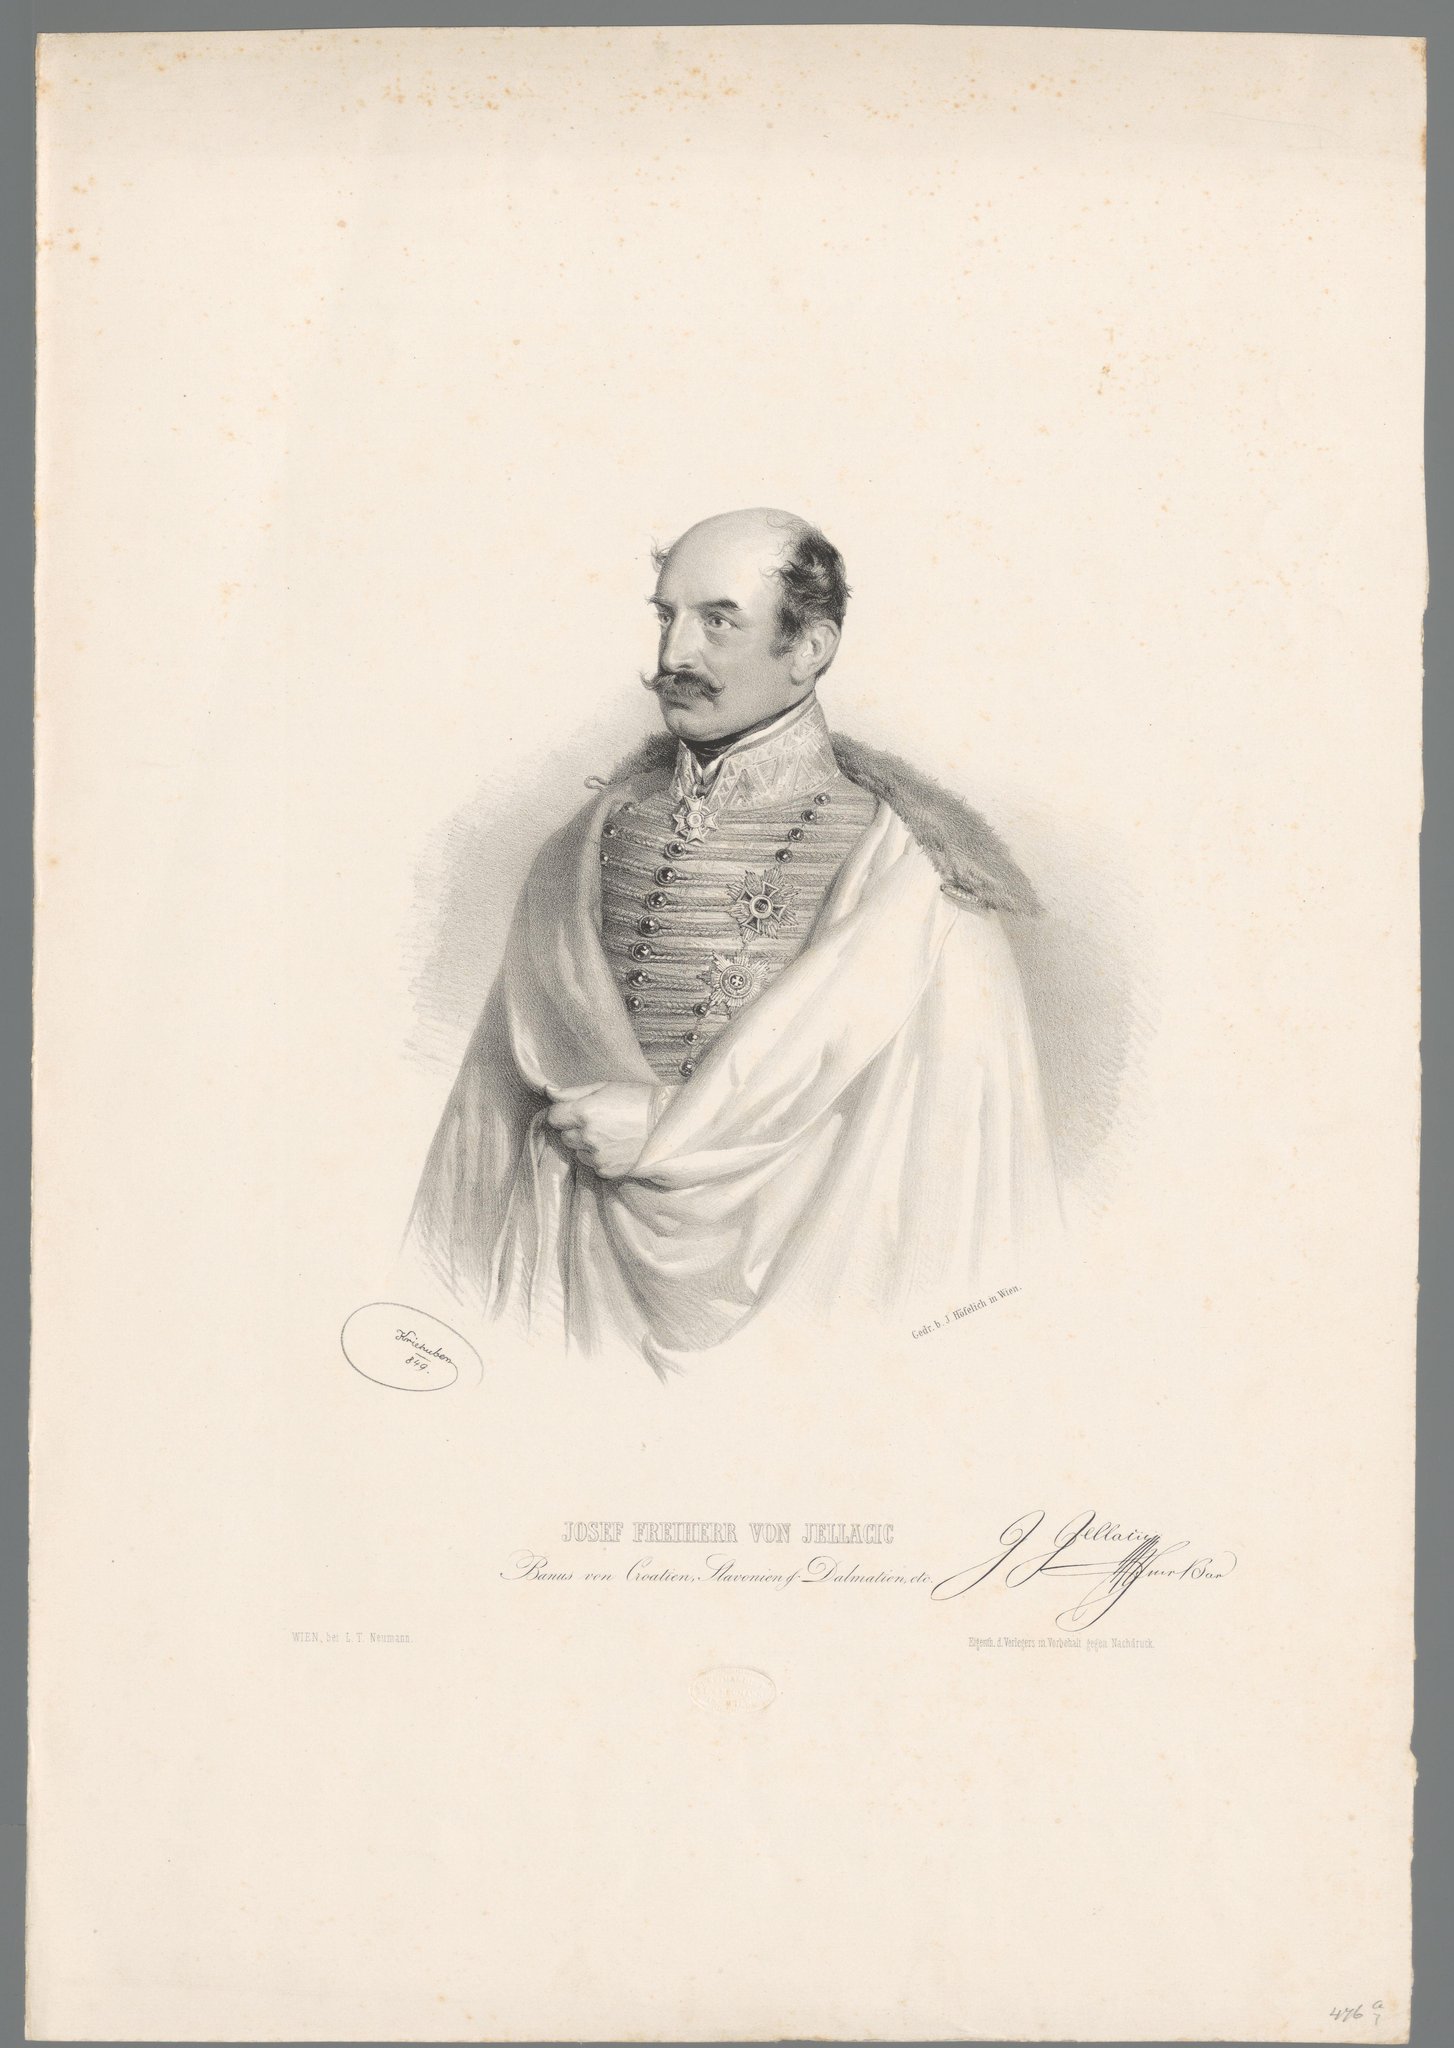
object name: print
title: Portret van Josip Jelačić od Bužima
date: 1849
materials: paper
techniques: lithograph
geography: vienna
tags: commander-in-chief, general, marshal, historical persons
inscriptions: collector's mark: Lugt 2228, check stamp: ‘Kunsthandlung L.T. Neumann in Wien’